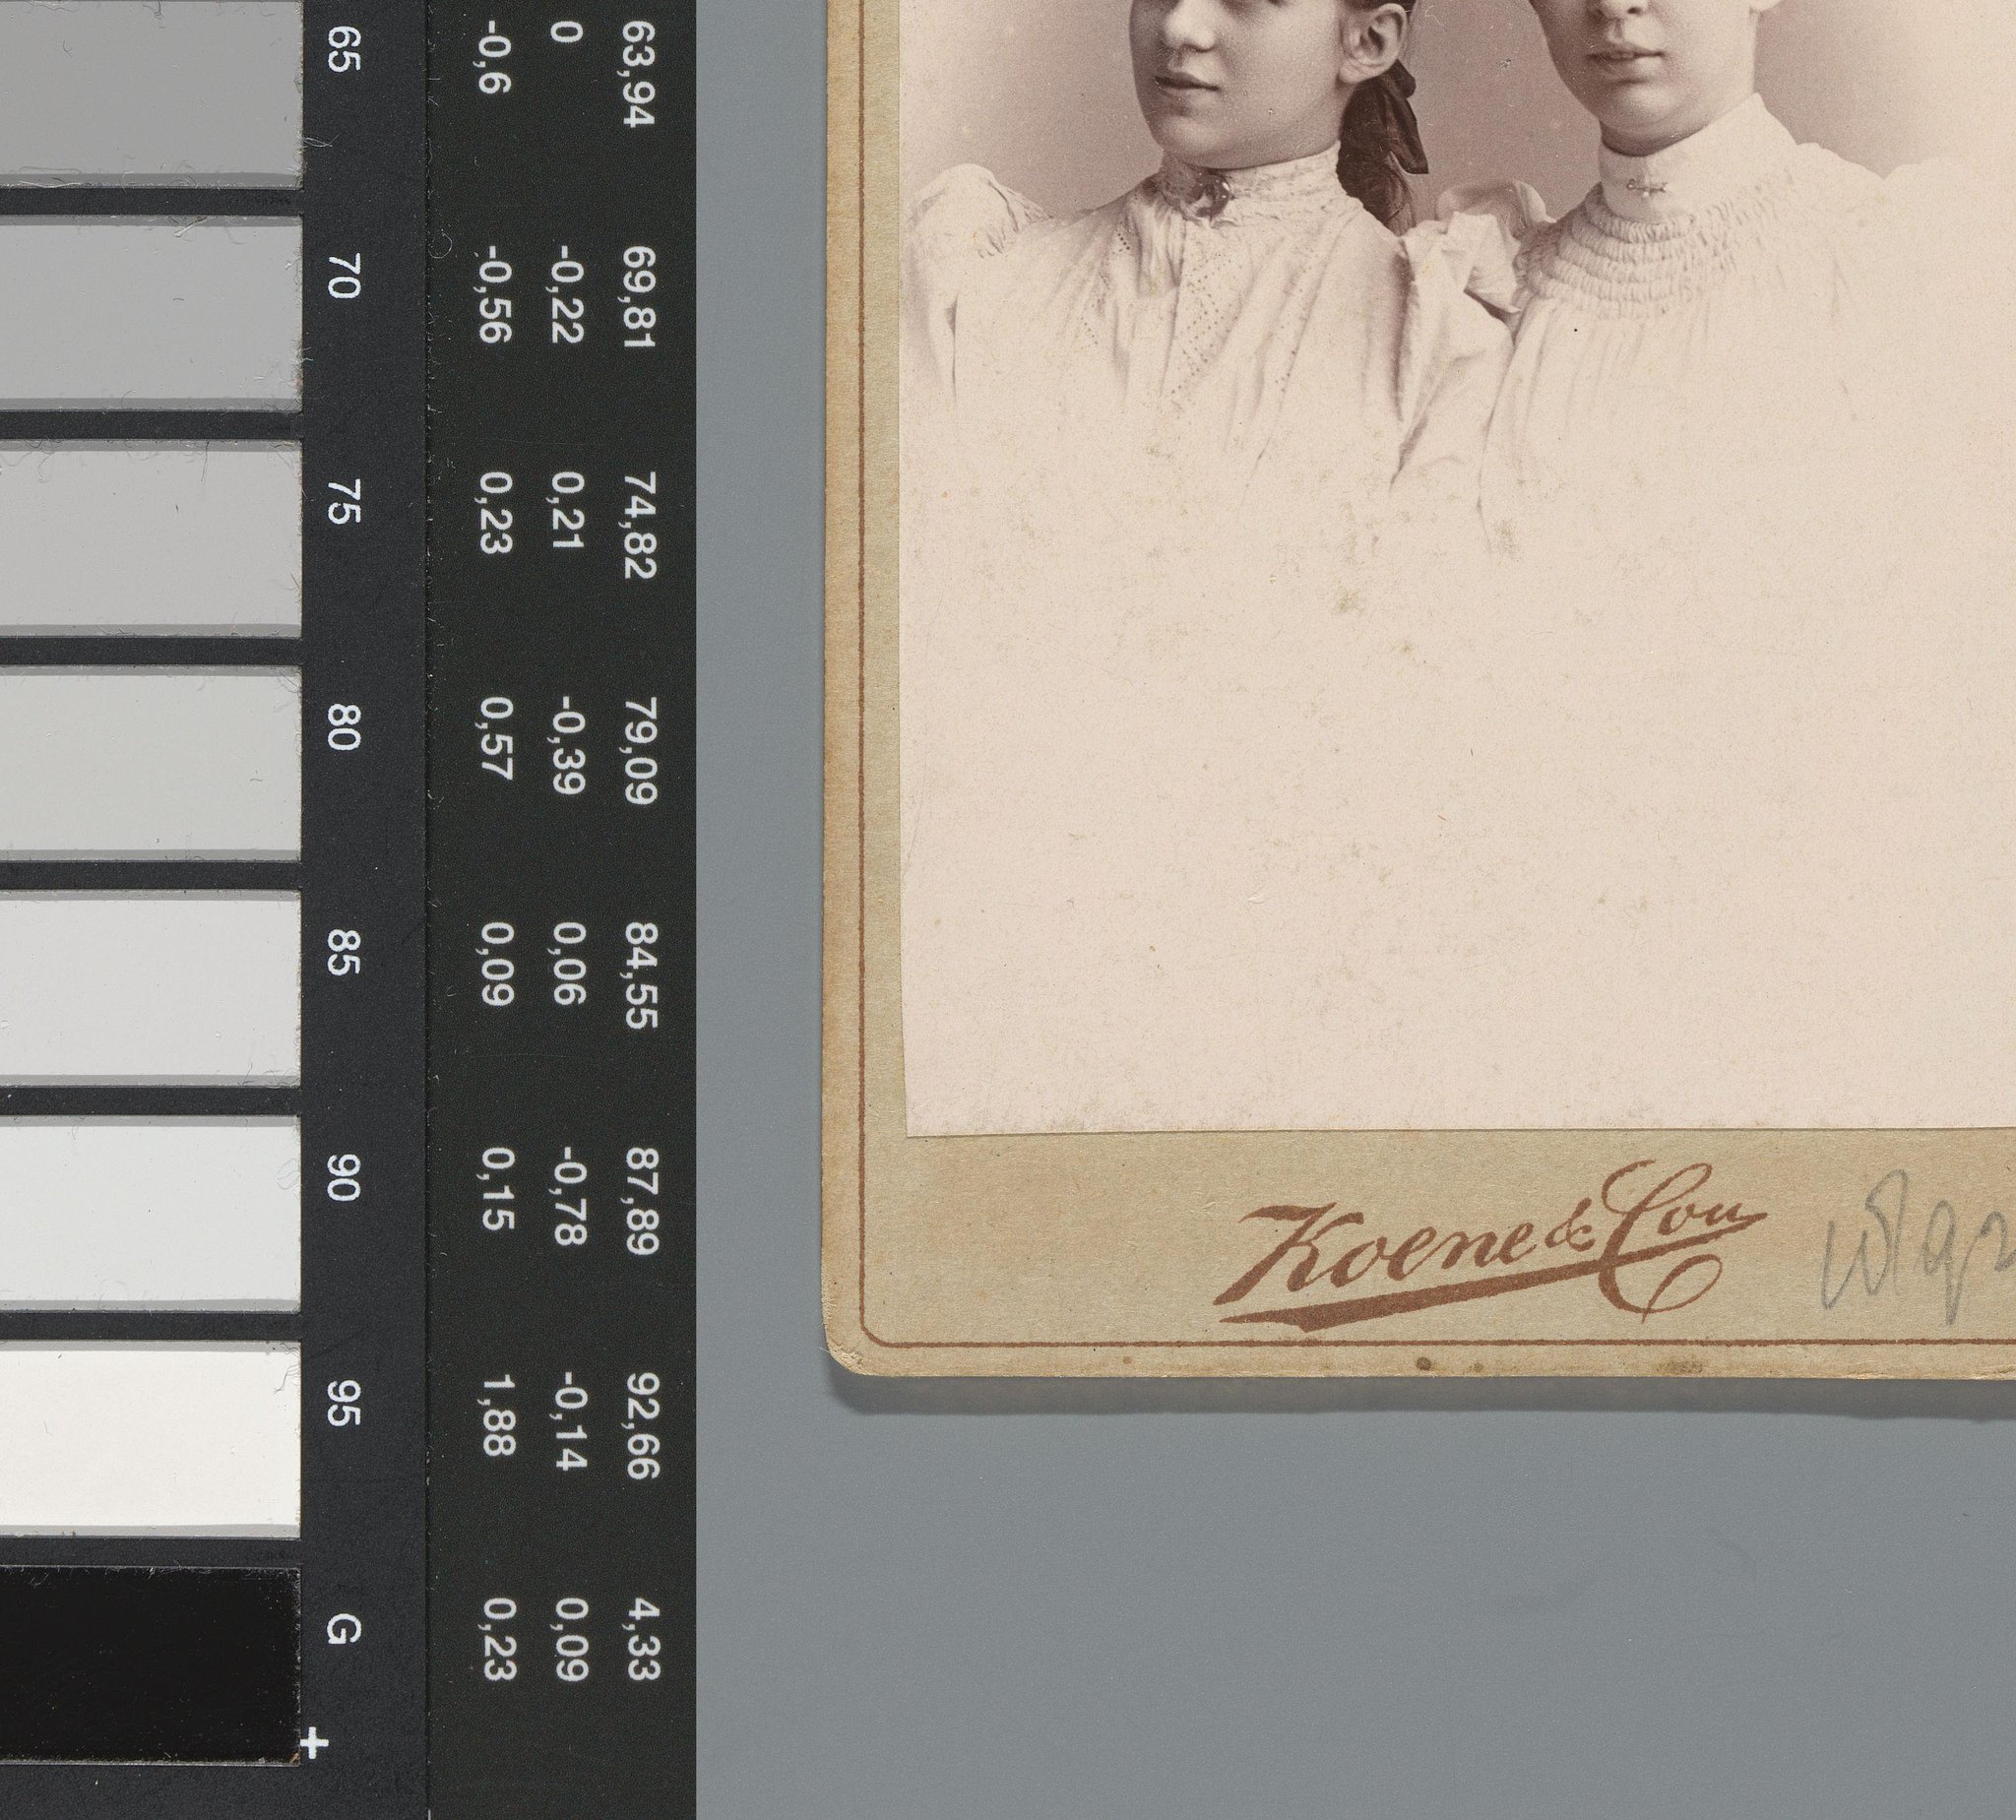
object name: carte de visite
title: Portret van twee meisjes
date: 1892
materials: cardboard, photographic support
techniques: albumen print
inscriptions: name: ‘BATAVIA / KOENE & CO / AMSTERDAM / ALKMAAR.’, name: ‘Koene & Co’, date: ‘1892’